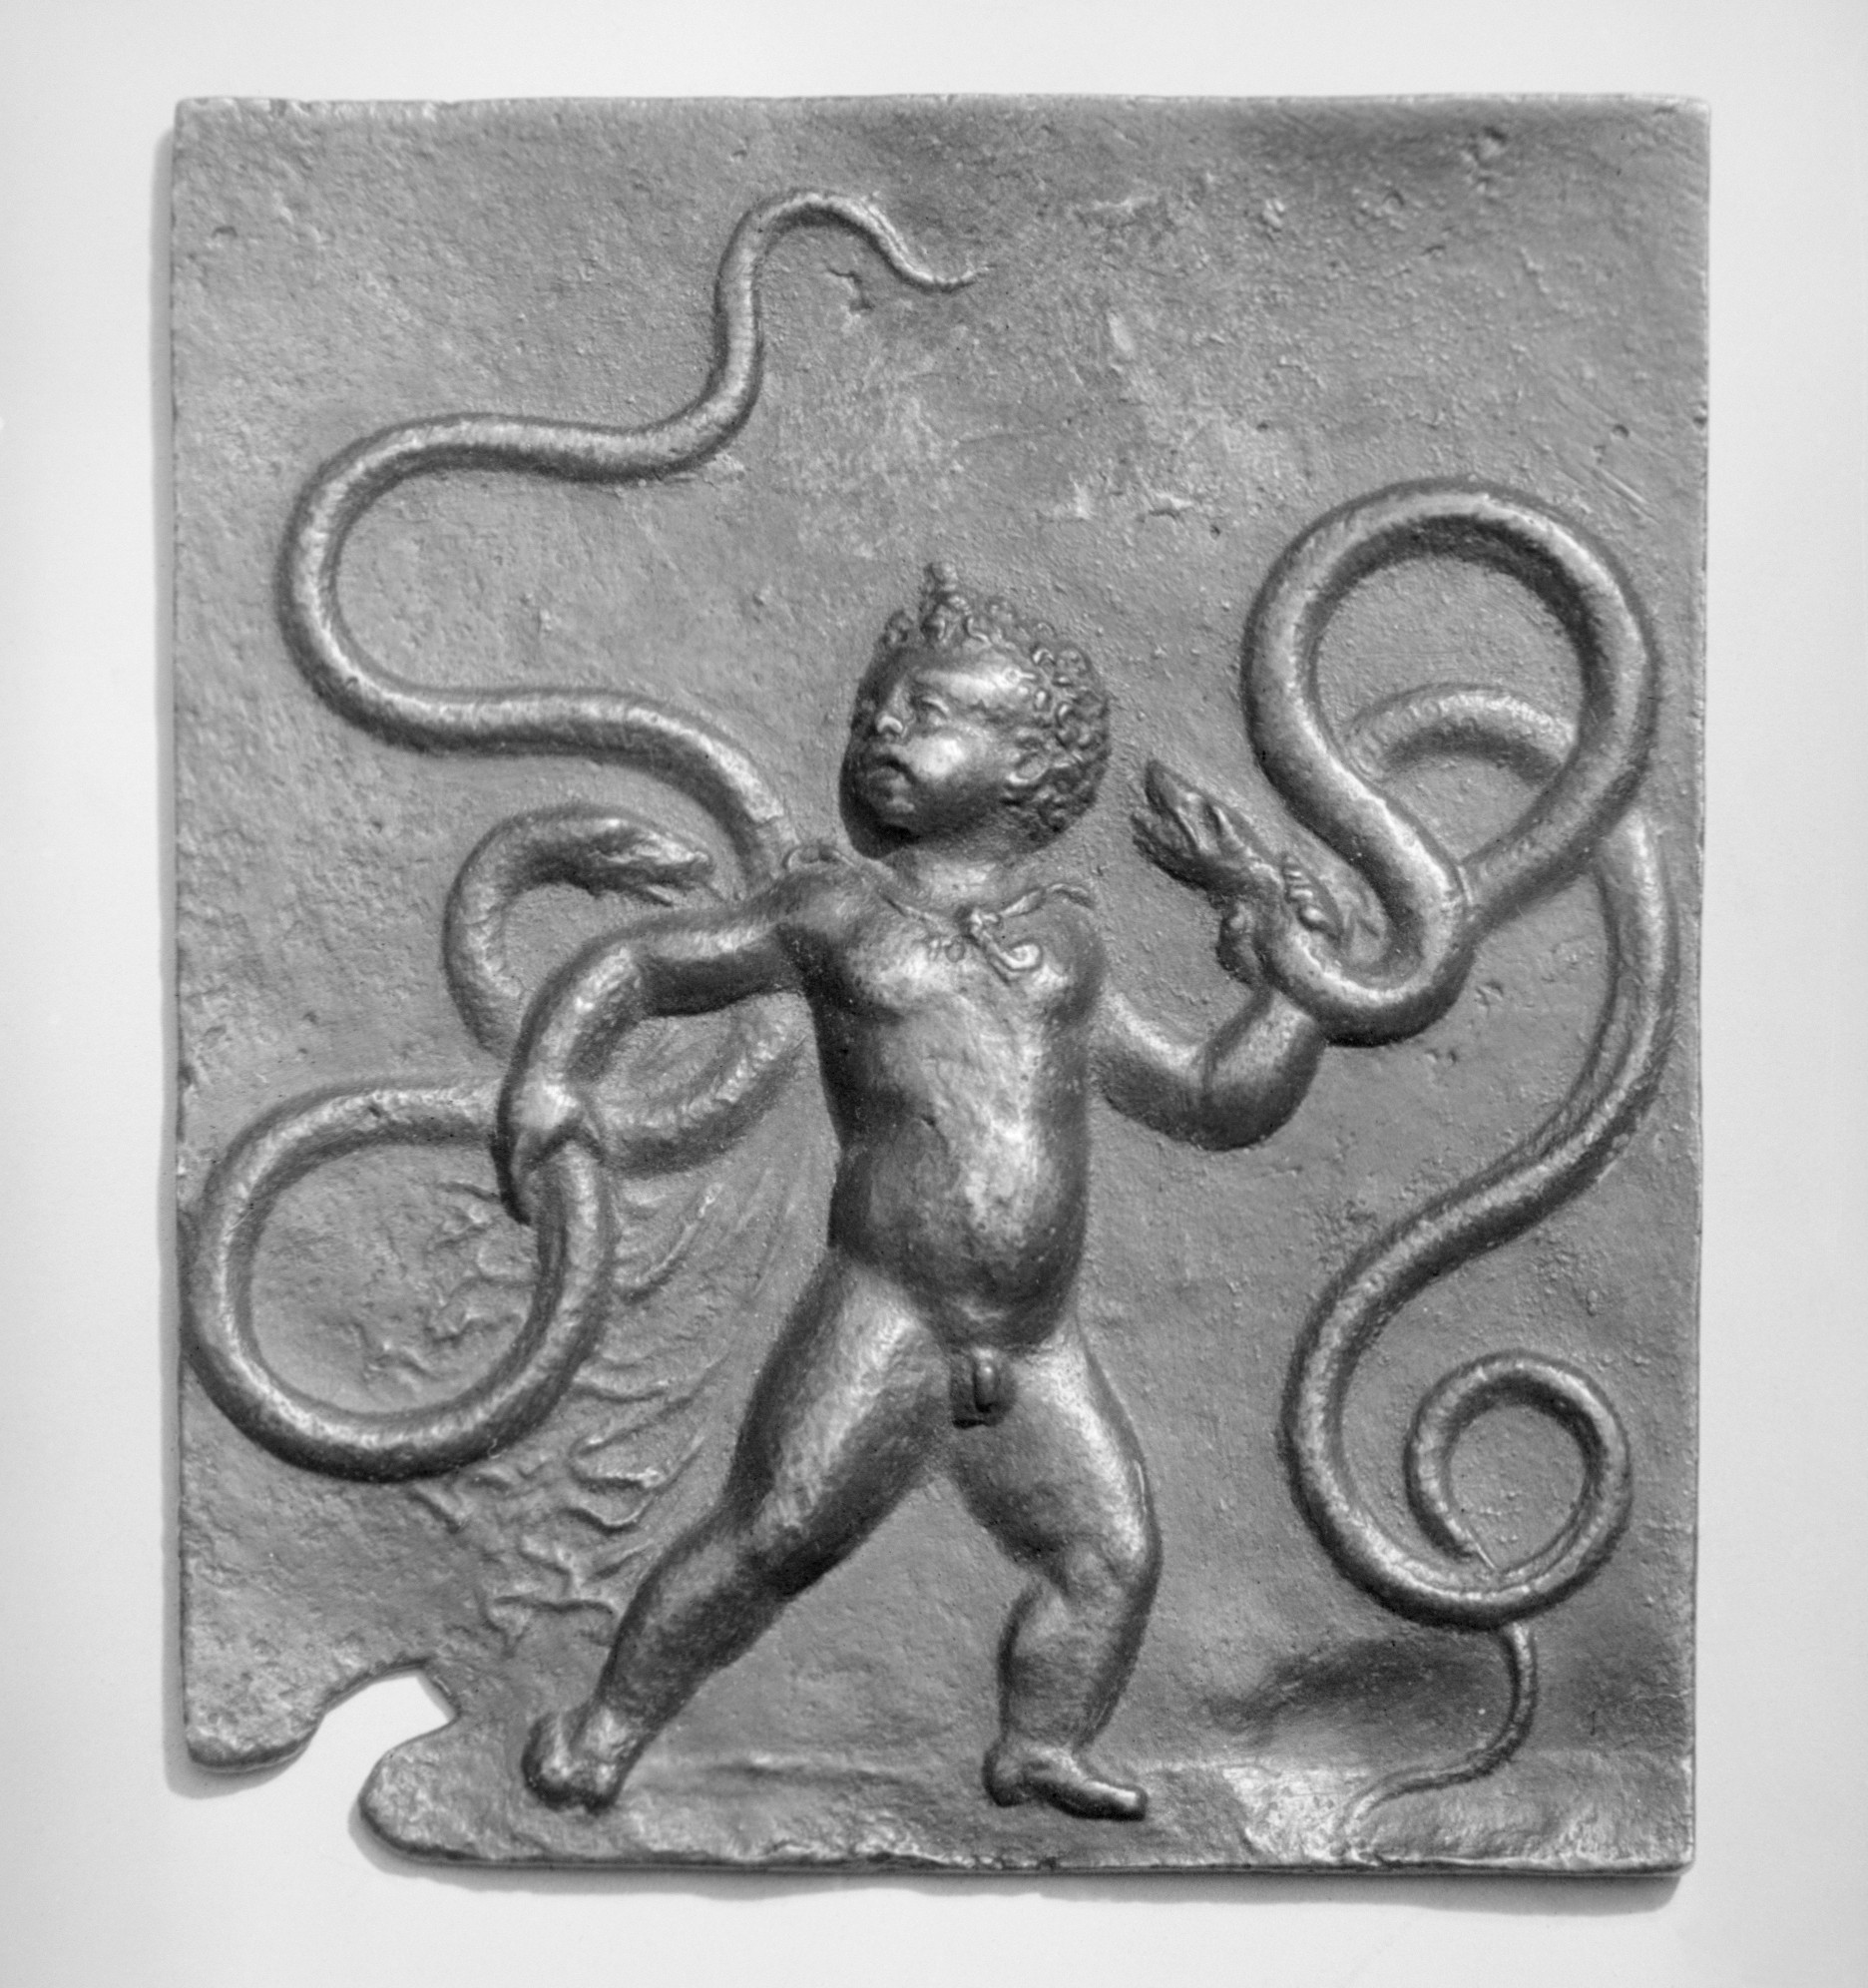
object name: plaquette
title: Infant Hercules Strangling Two Serpents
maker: moderno (galeazzo mondella)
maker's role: maker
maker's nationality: italian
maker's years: 1467-1528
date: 1467-1533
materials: bronze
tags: infants,hercules,serpents